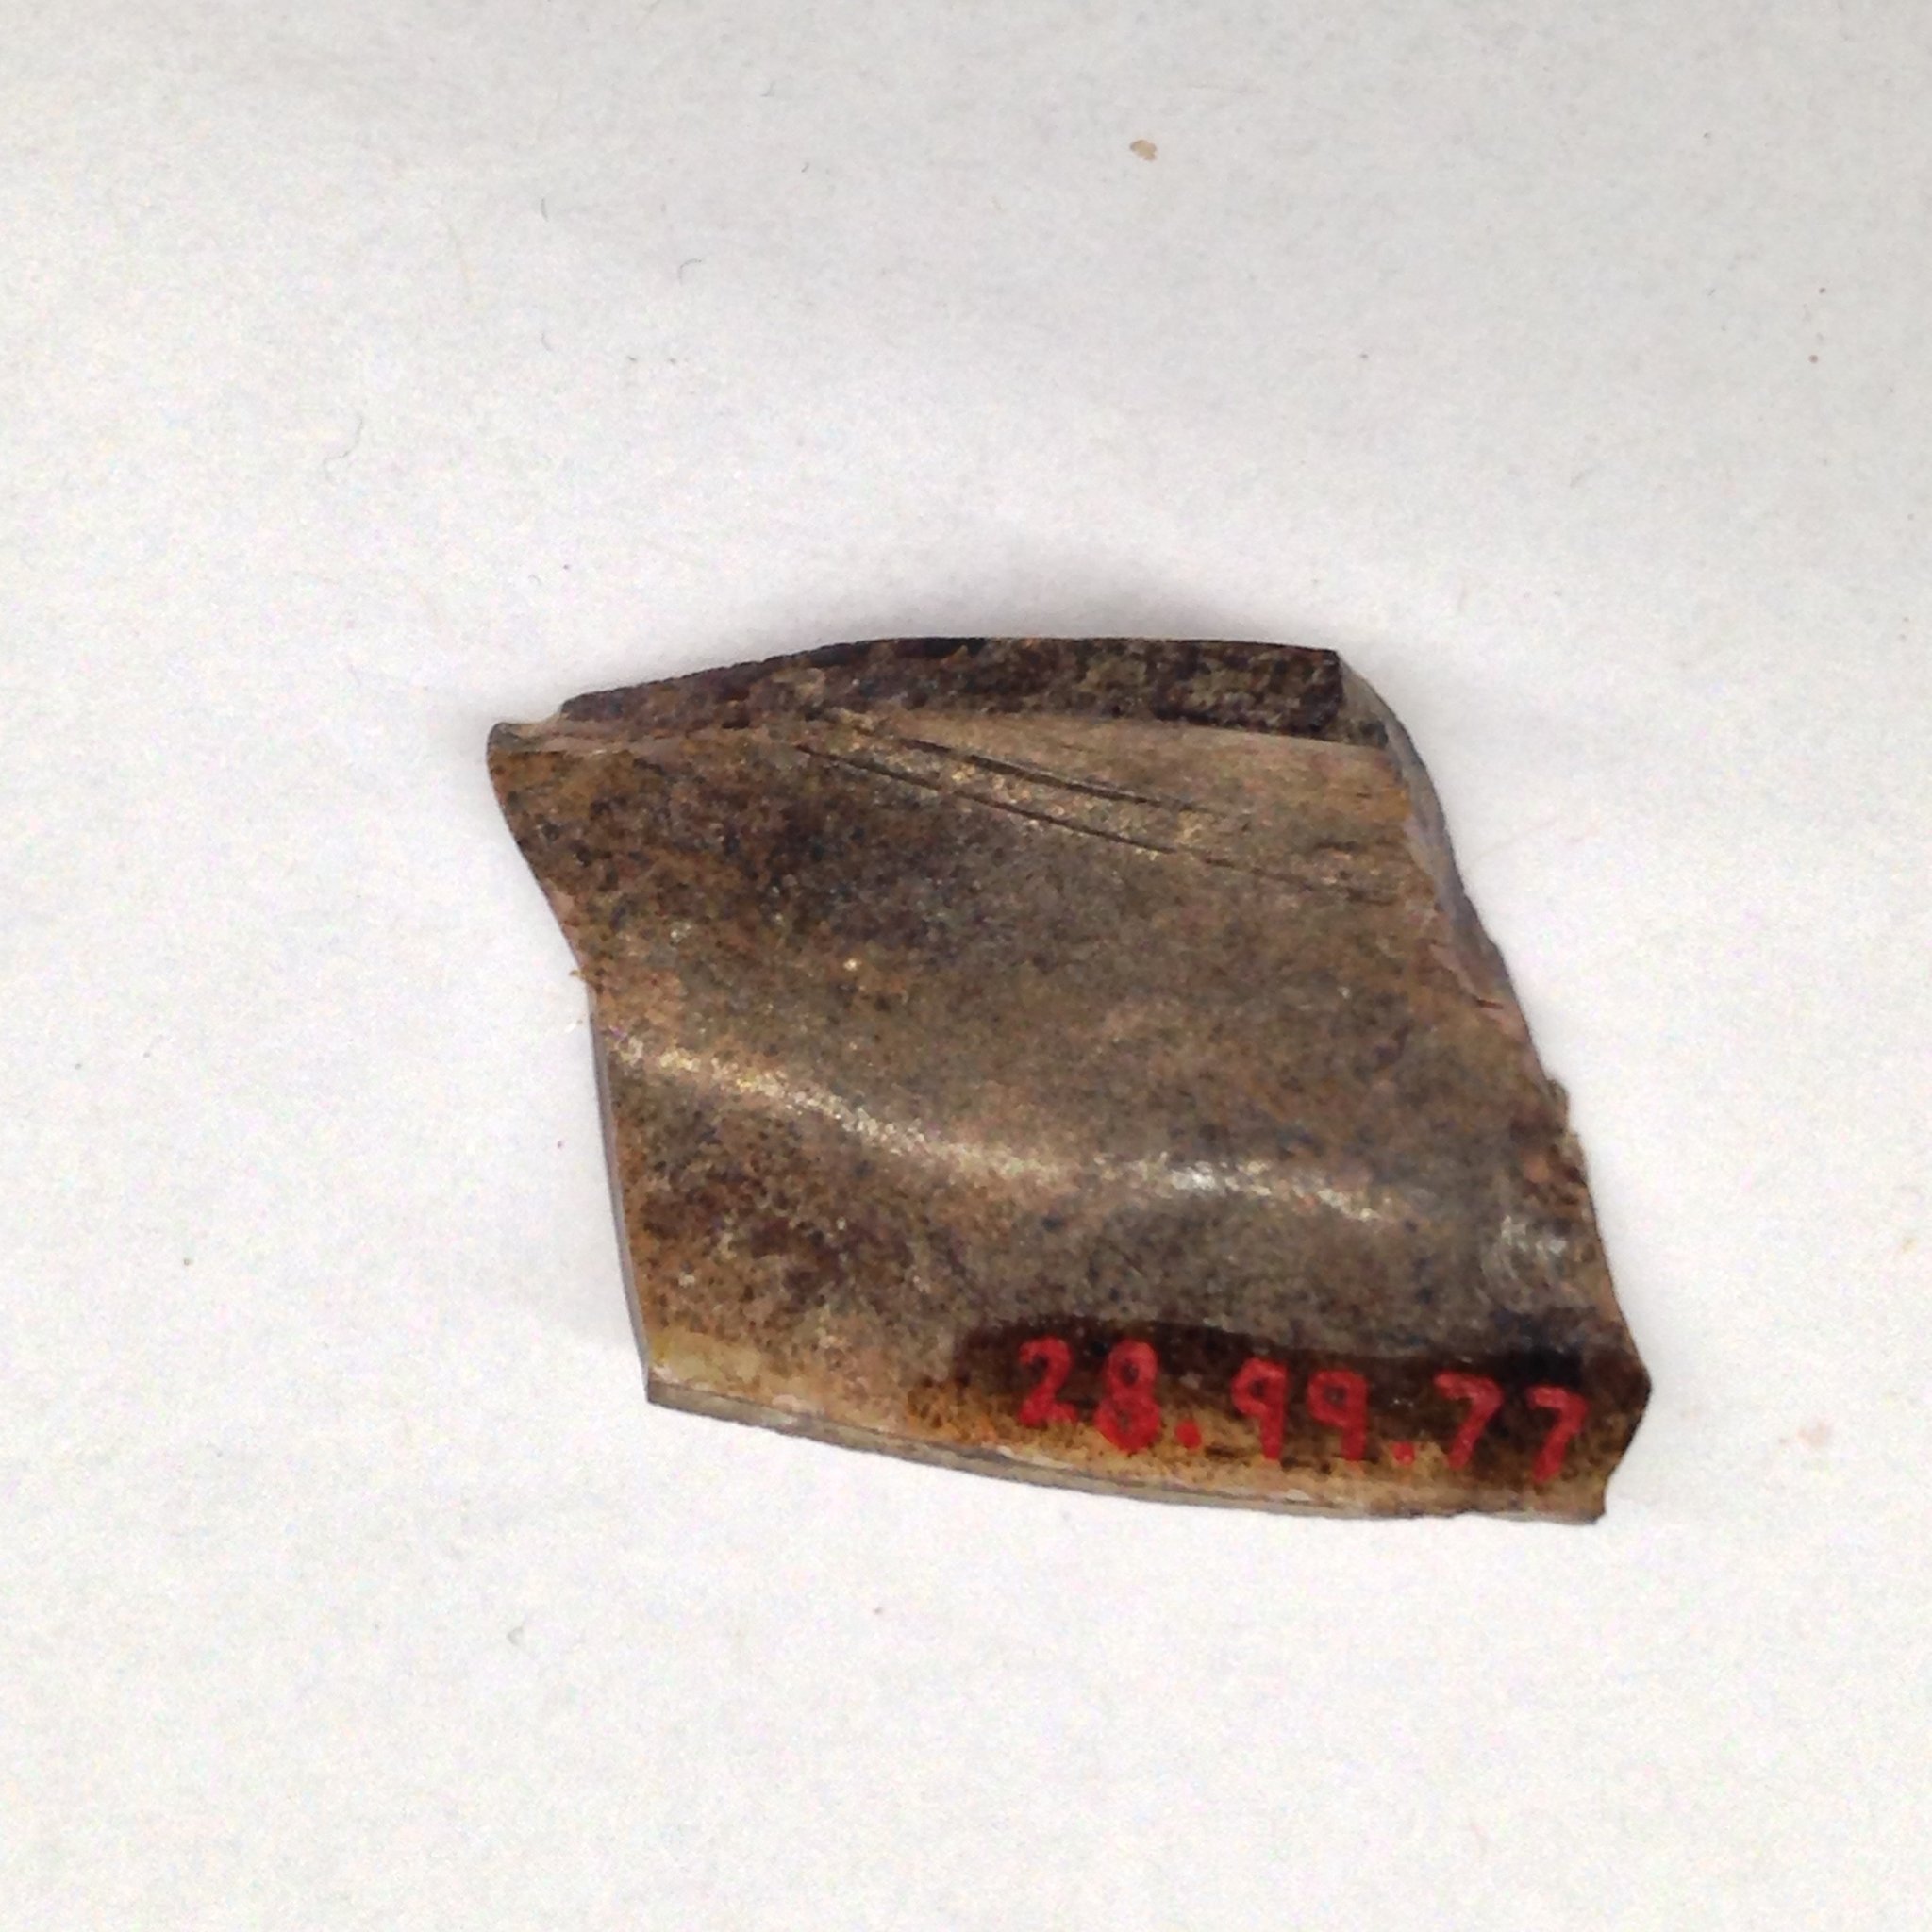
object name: fragment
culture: european or middle eastern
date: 1150-1250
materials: ceramic, glass